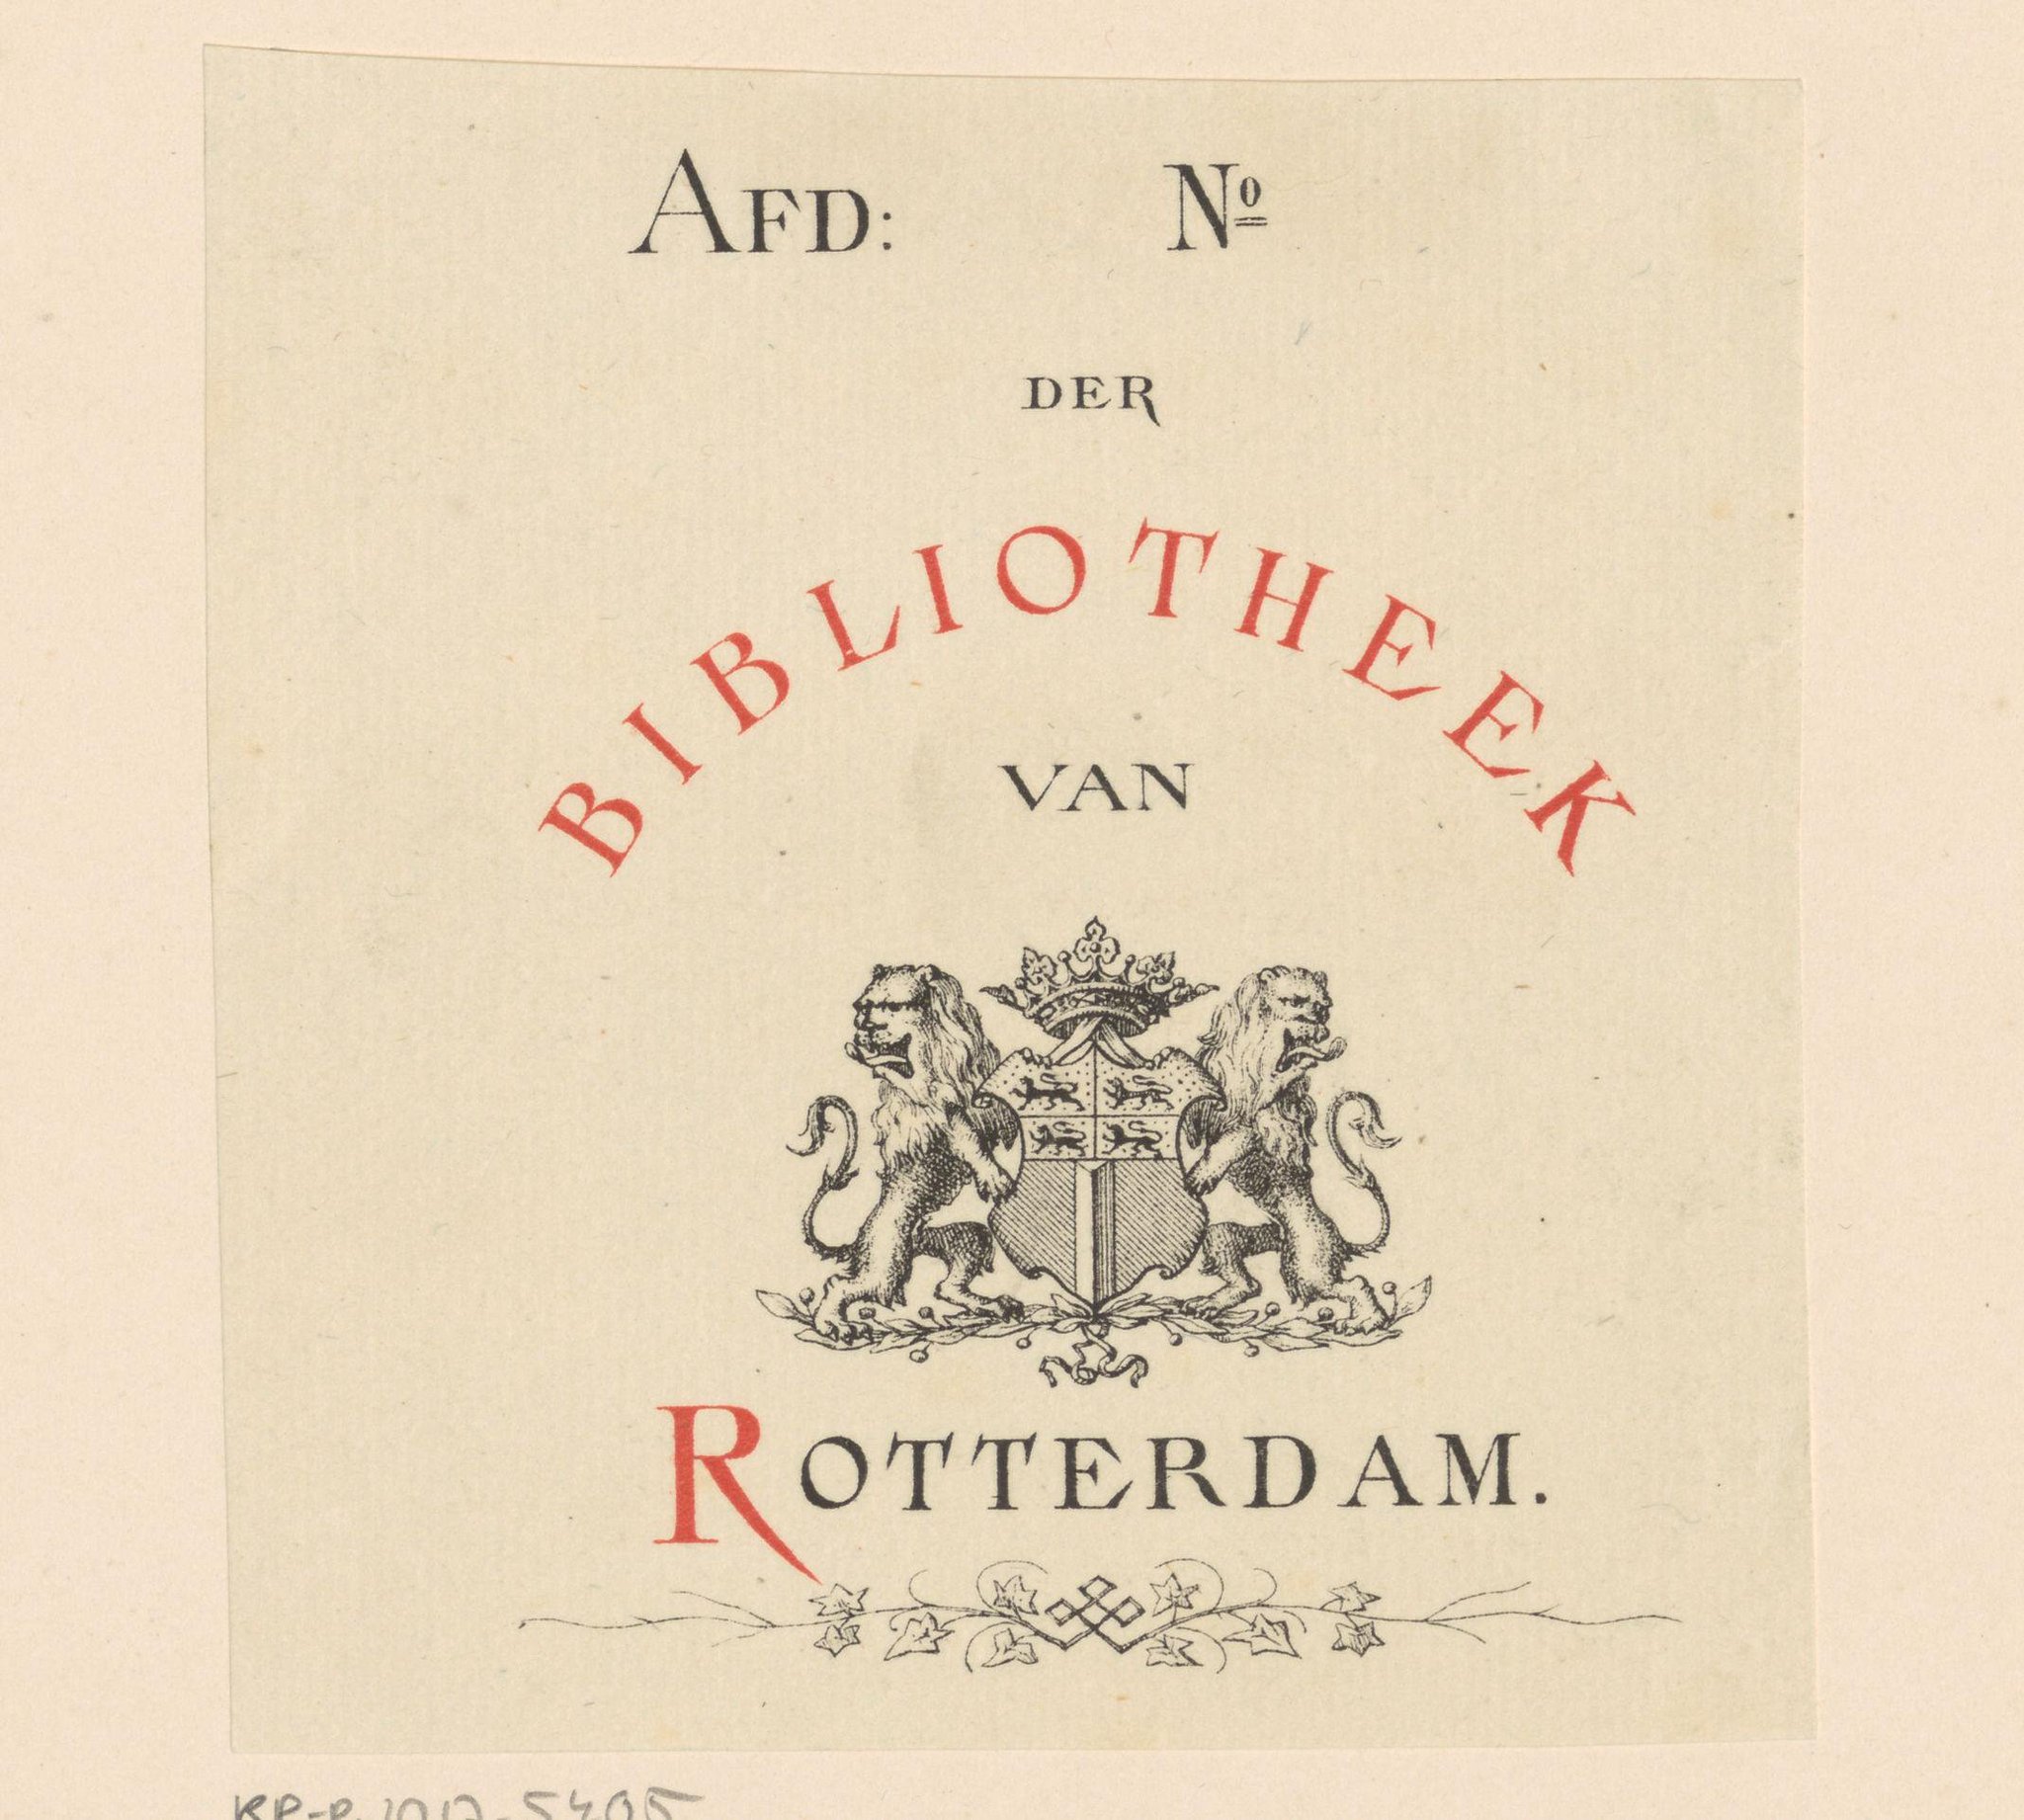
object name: bookplate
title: Ex libris van de Bibliotheek van Rotterdam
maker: Anonymous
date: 1870-1923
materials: paper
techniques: printing block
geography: netherlands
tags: beasts of prey, predatory animals: lion, armorial bearing, heraldry, rotterdam